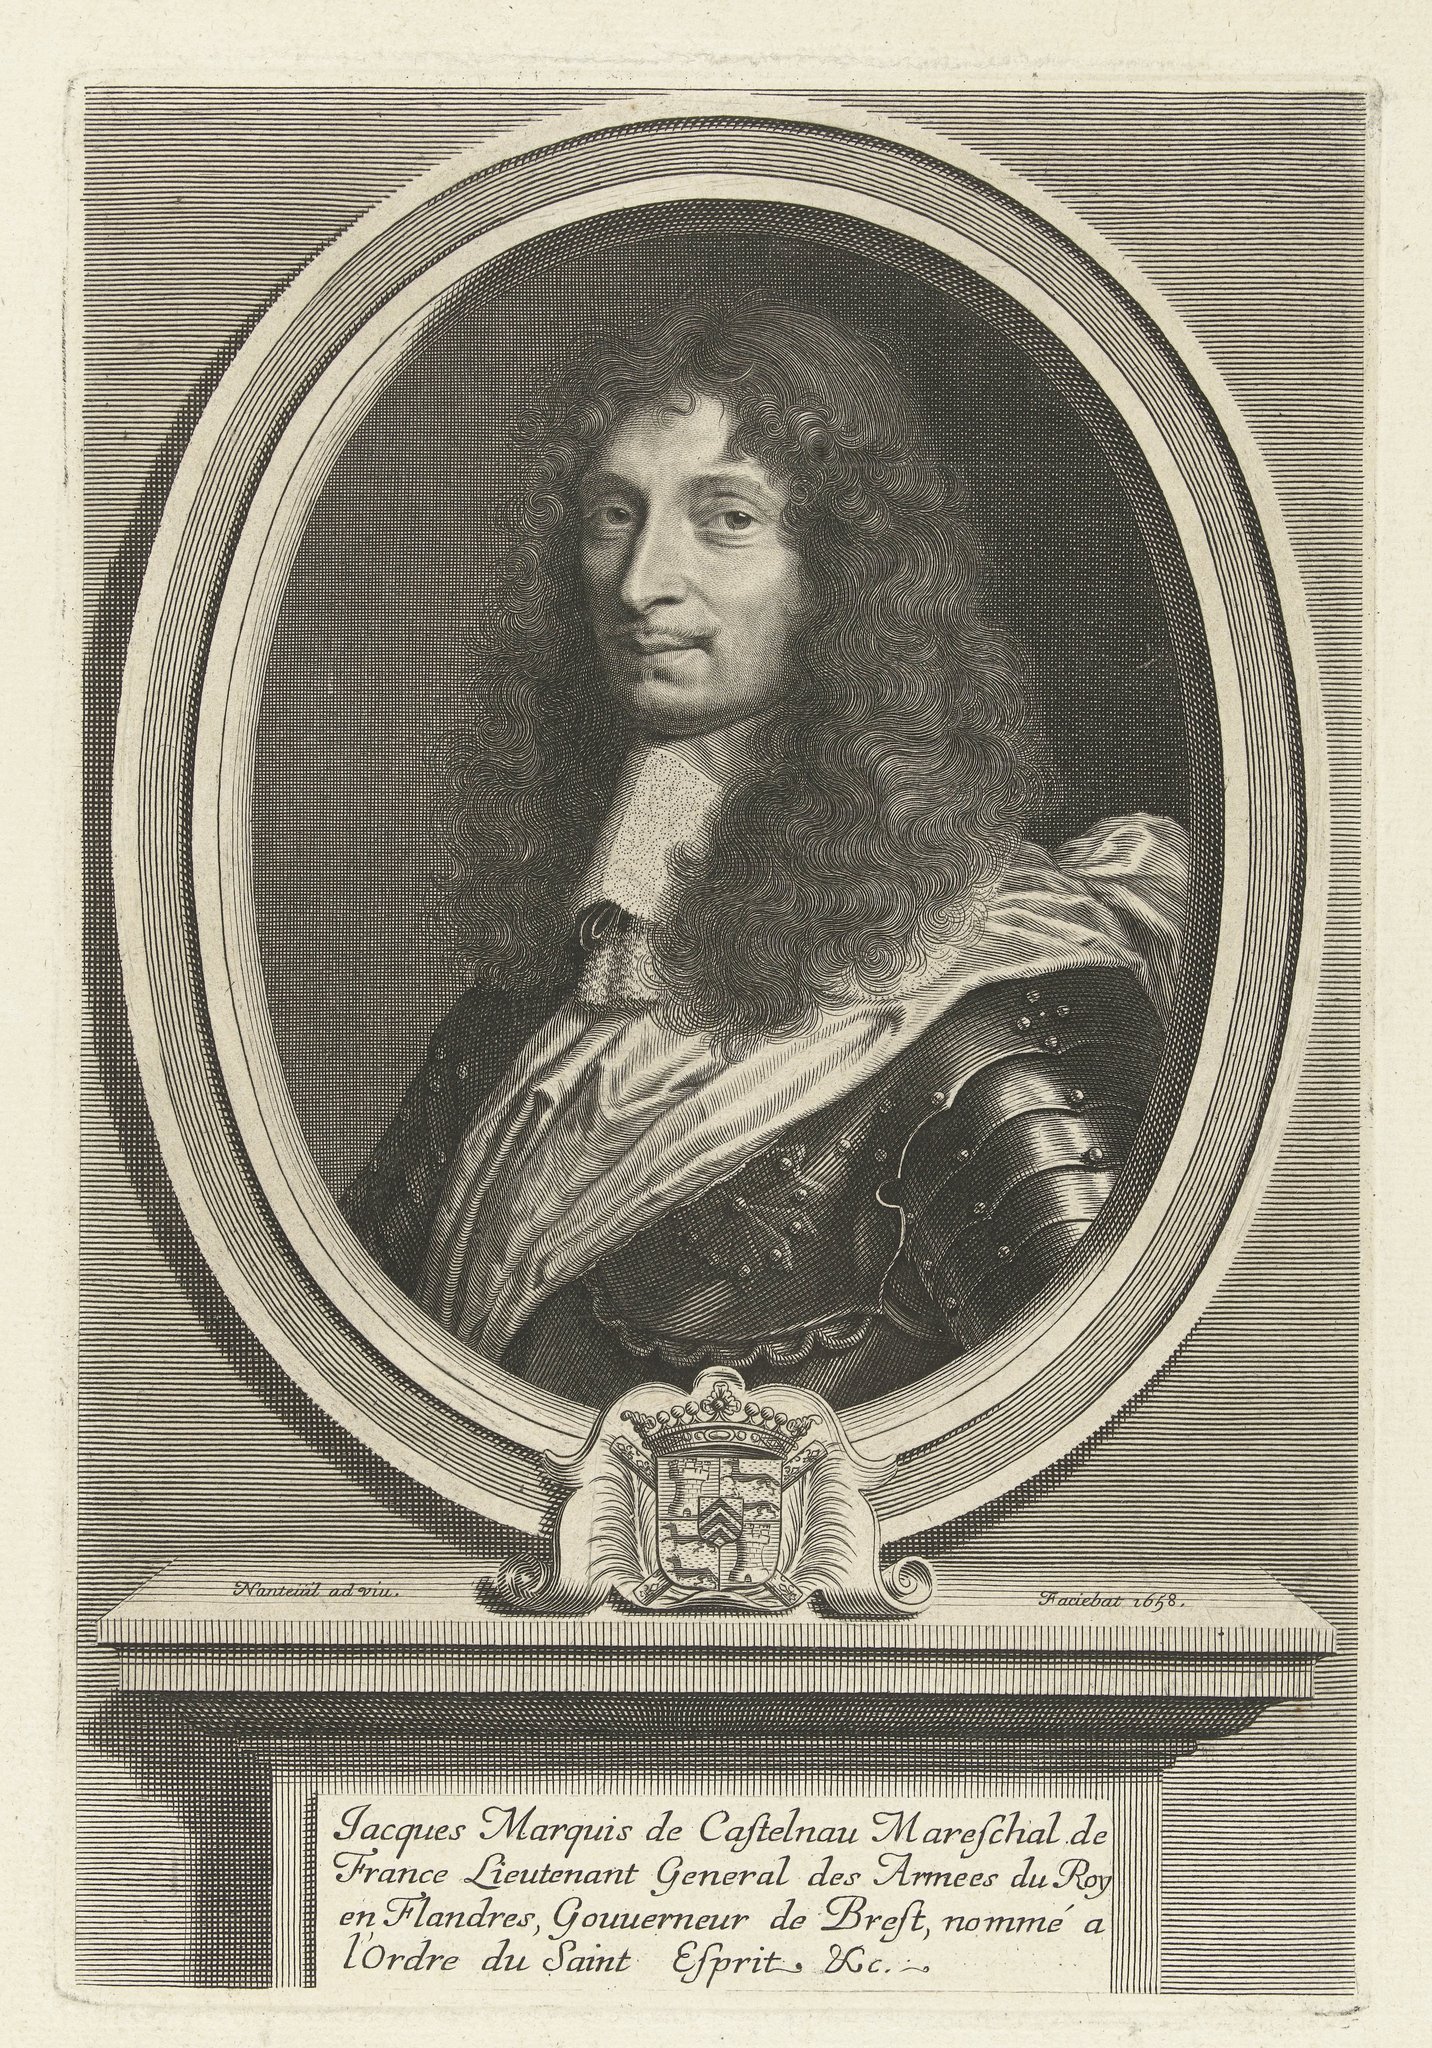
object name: print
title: Jacques marquis de Castelnau Mareschal de France (...)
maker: robert nanteuil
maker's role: print maker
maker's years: 1623-1678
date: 1658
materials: paper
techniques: engraving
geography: france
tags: jacques de castelnau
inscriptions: collector's mark: Lugt 684, collector's mark: Lugt 253, collector's mark: Lugt 2228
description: Portret van Jacques II de Castelnau-Mauvissière, markies van Castelnau, driekwart naar links, in een harnas met sjerp. Een ovale omlijsting met onderaan een wapenschild, staand op een piëdestal met daarop een vierregelige tekst in het Frans.